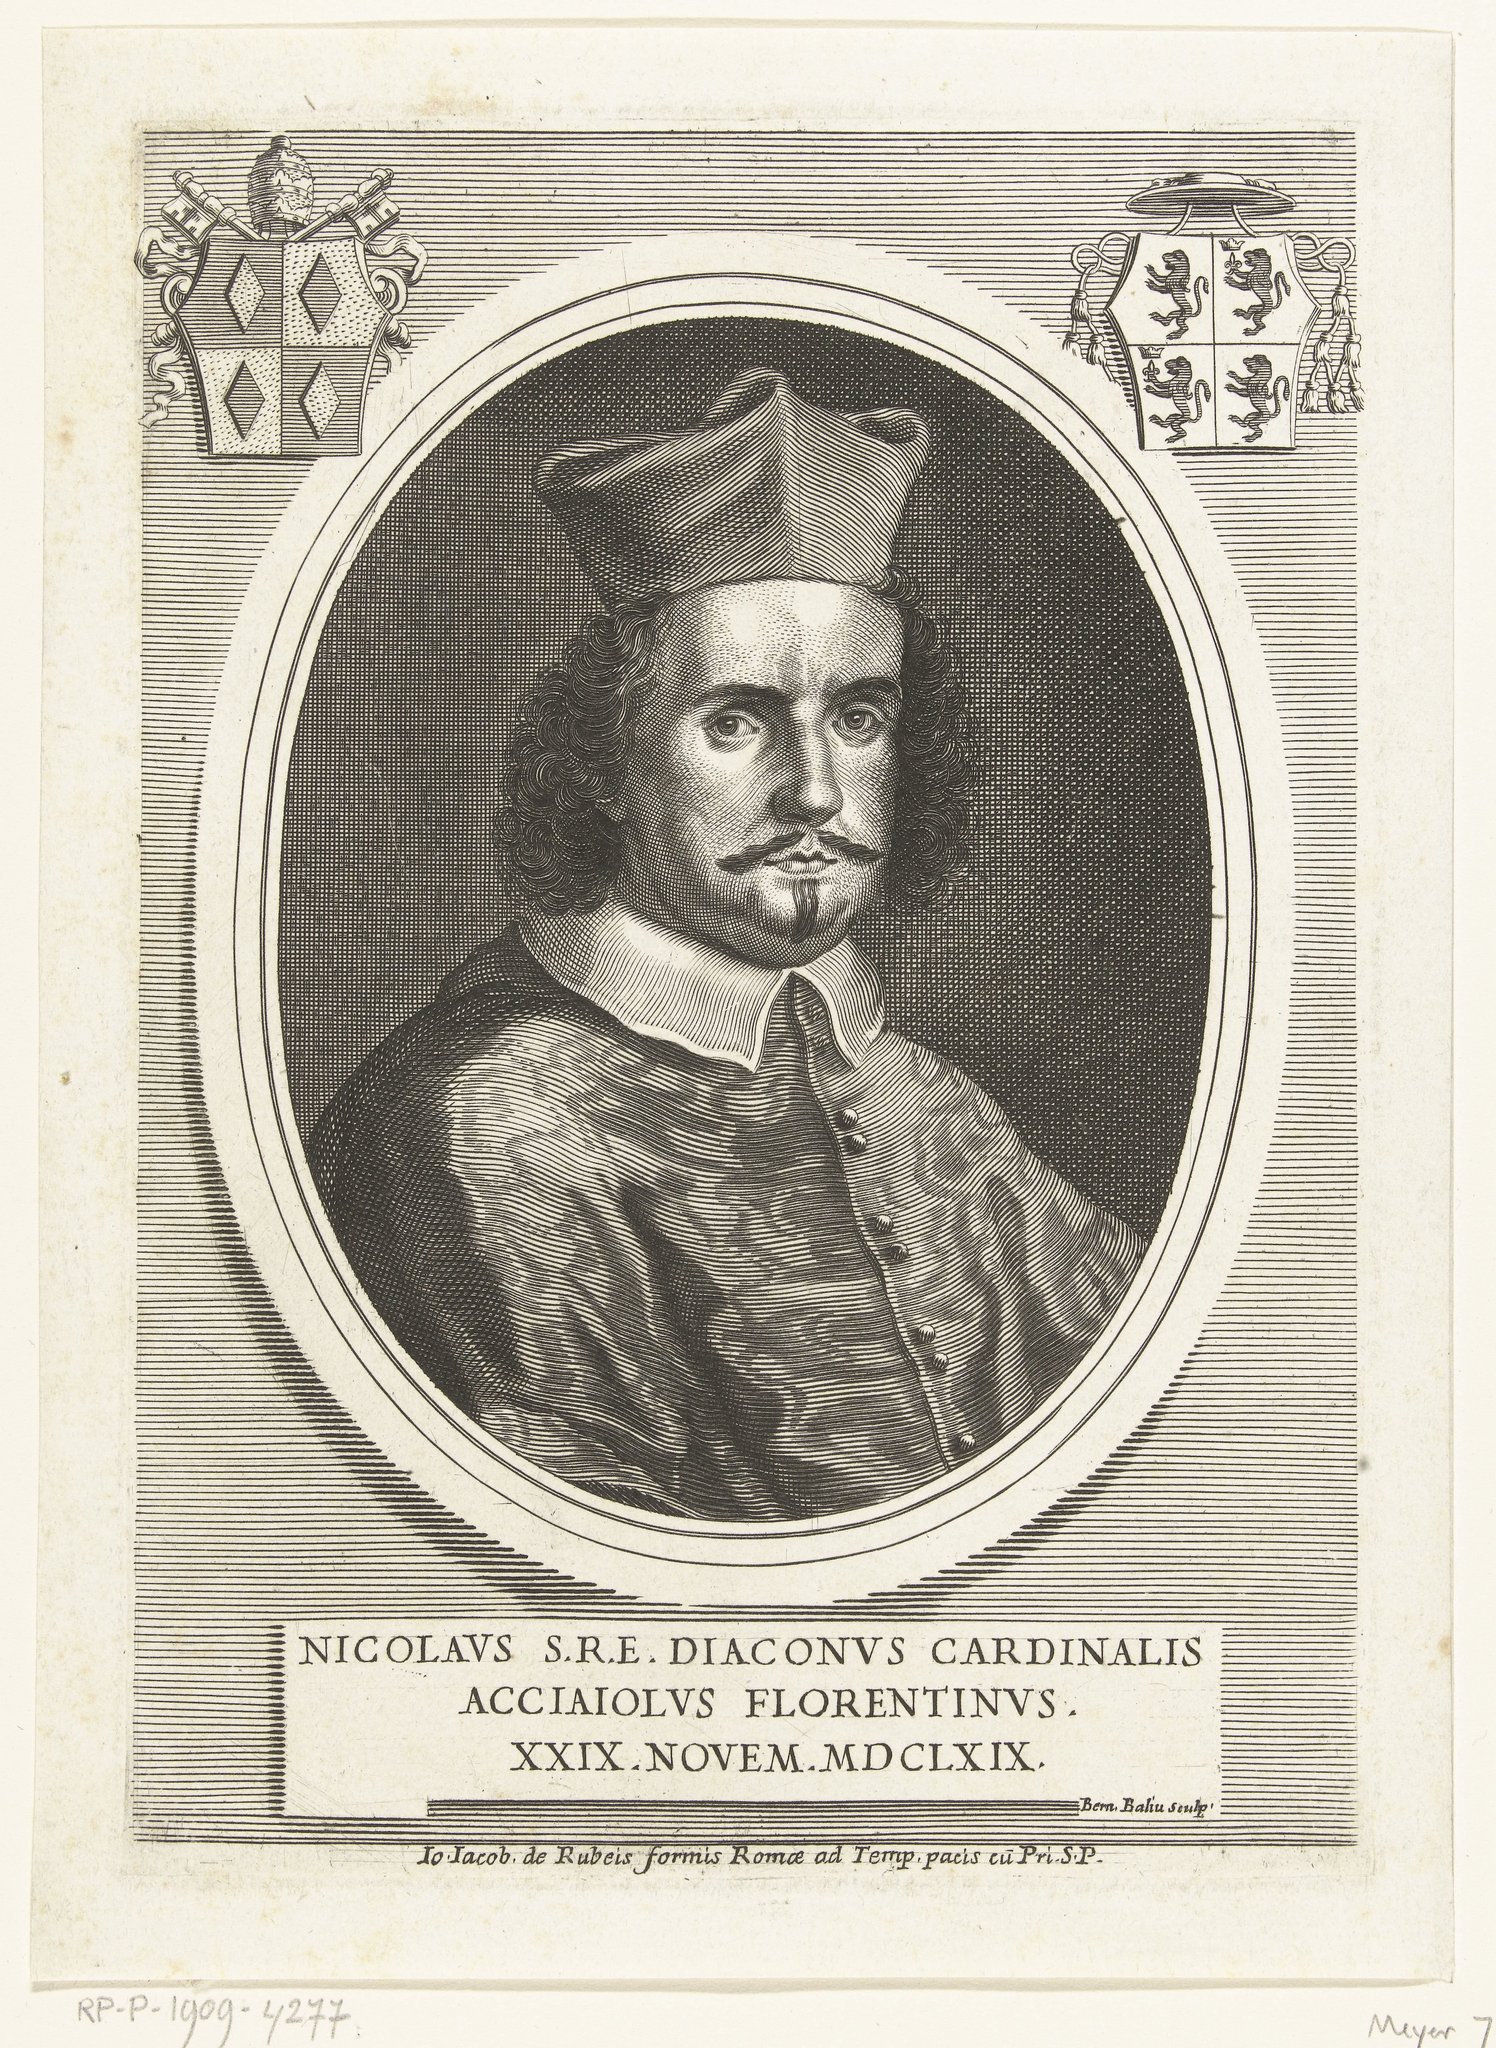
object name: print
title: Nicolaus S.R.E. diaconus cardinalis accianolis florentinus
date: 1668-1704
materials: paper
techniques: engraving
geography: rome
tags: rome, cardinal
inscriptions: collector's mark: Lugt 2228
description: Portret van kardinaal Nicolò Acciaioli in ovale omlijsting met twee wapenschilden. Hij verwierf het ambt van kardinaal op 29 november 1669 aldus het opschrift.